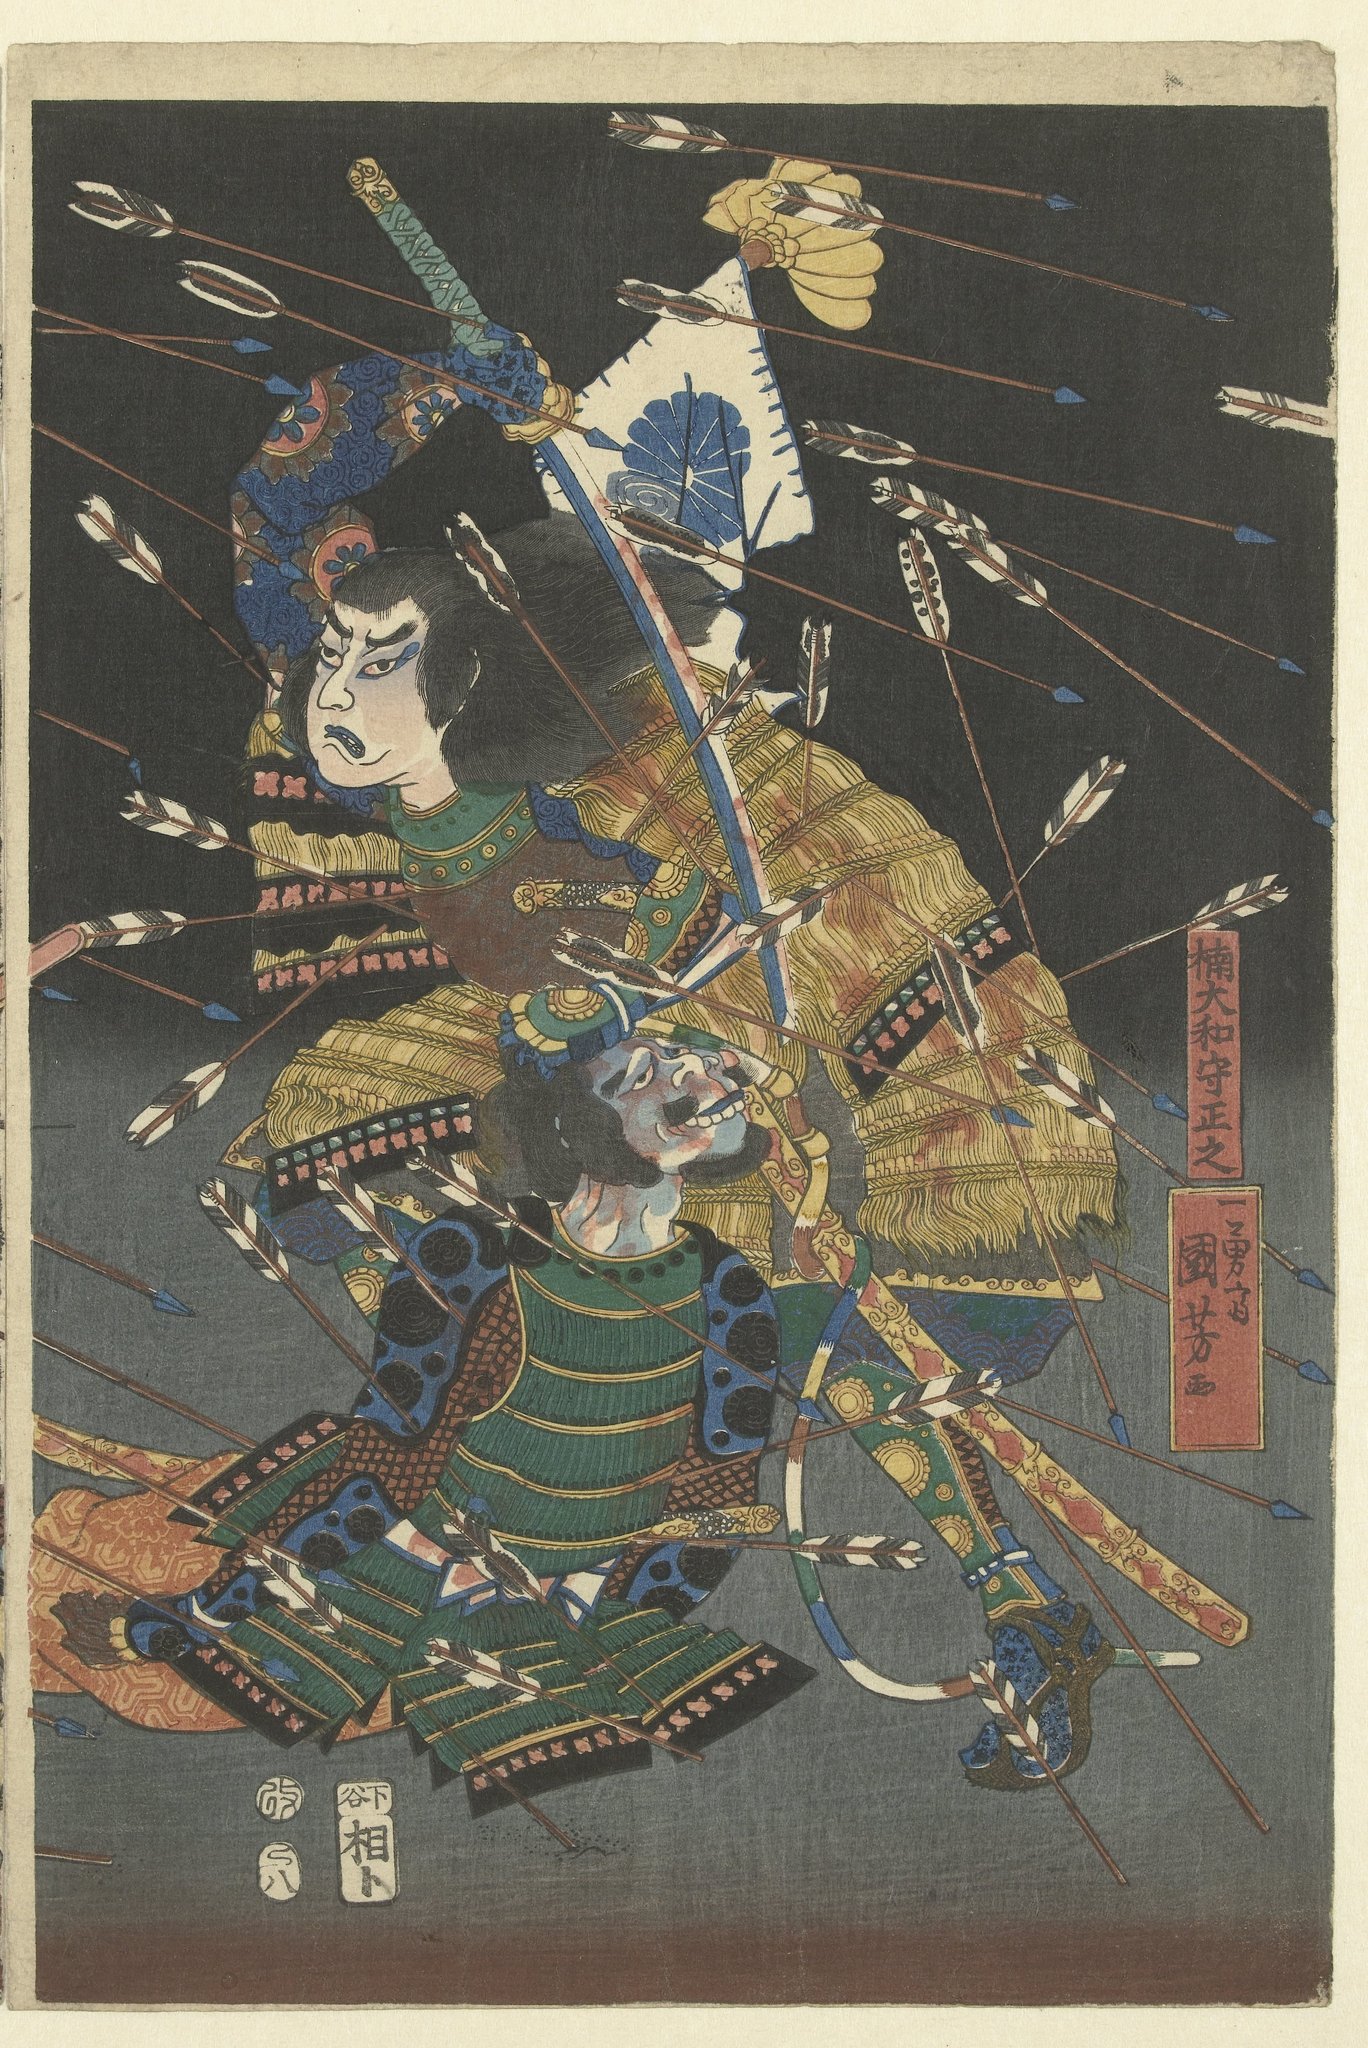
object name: print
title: Shijonawate nite Nanke no eiyu taiteki o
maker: utagawa kuniyoshi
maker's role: draughtsman, print maker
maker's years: 1798-1861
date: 1847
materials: paper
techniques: woodcut, nishiki e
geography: japan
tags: battle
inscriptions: collector's mark: Lugt 2760, collector's mark: Lugt 2228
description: Krijger van de Kusunoki clan, met dode tegenstander, tijdens een pijlenaanval van de Ashikaga troepen te Shijonawate. Zesde blad van zesluik.